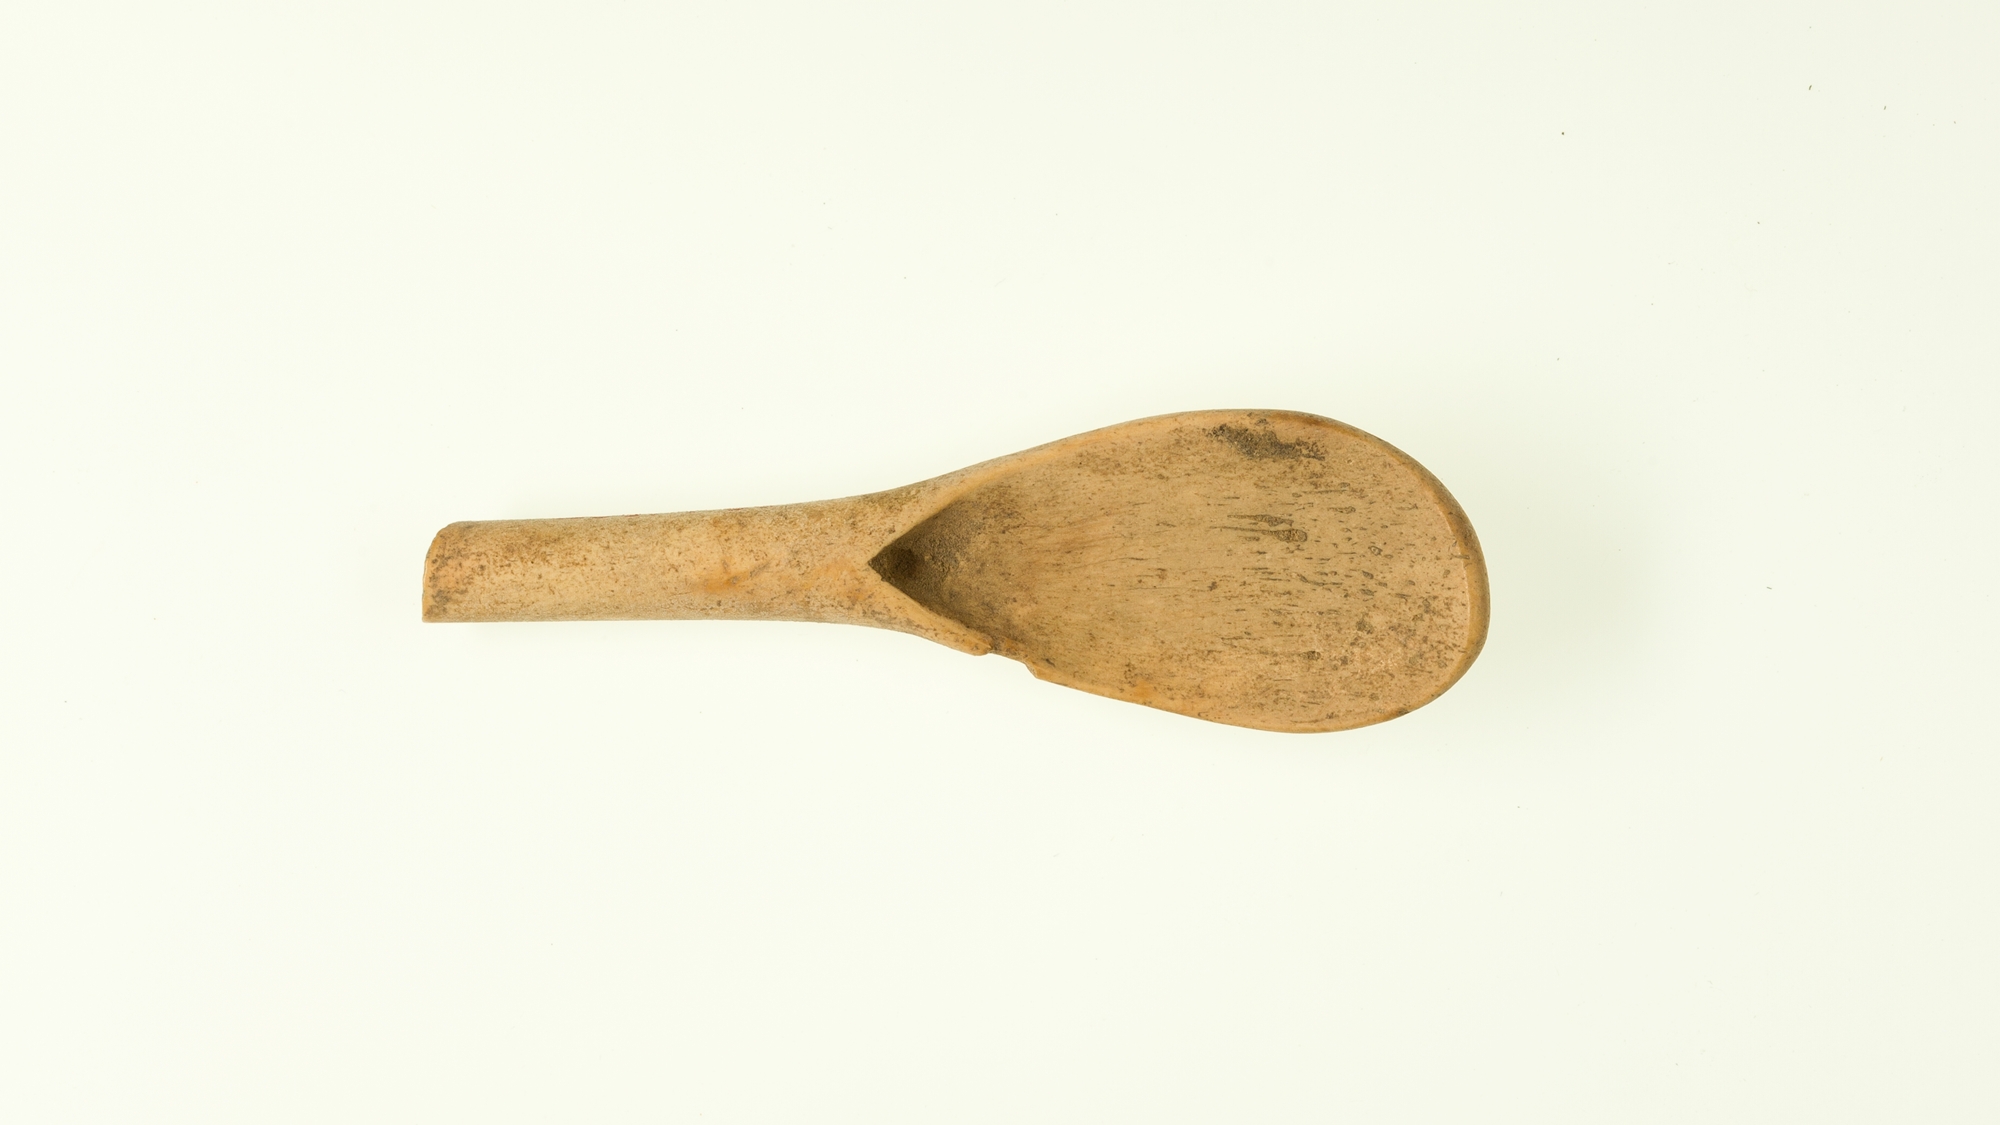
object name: spoon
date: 1295-1070 BCE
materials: bone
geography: egypt